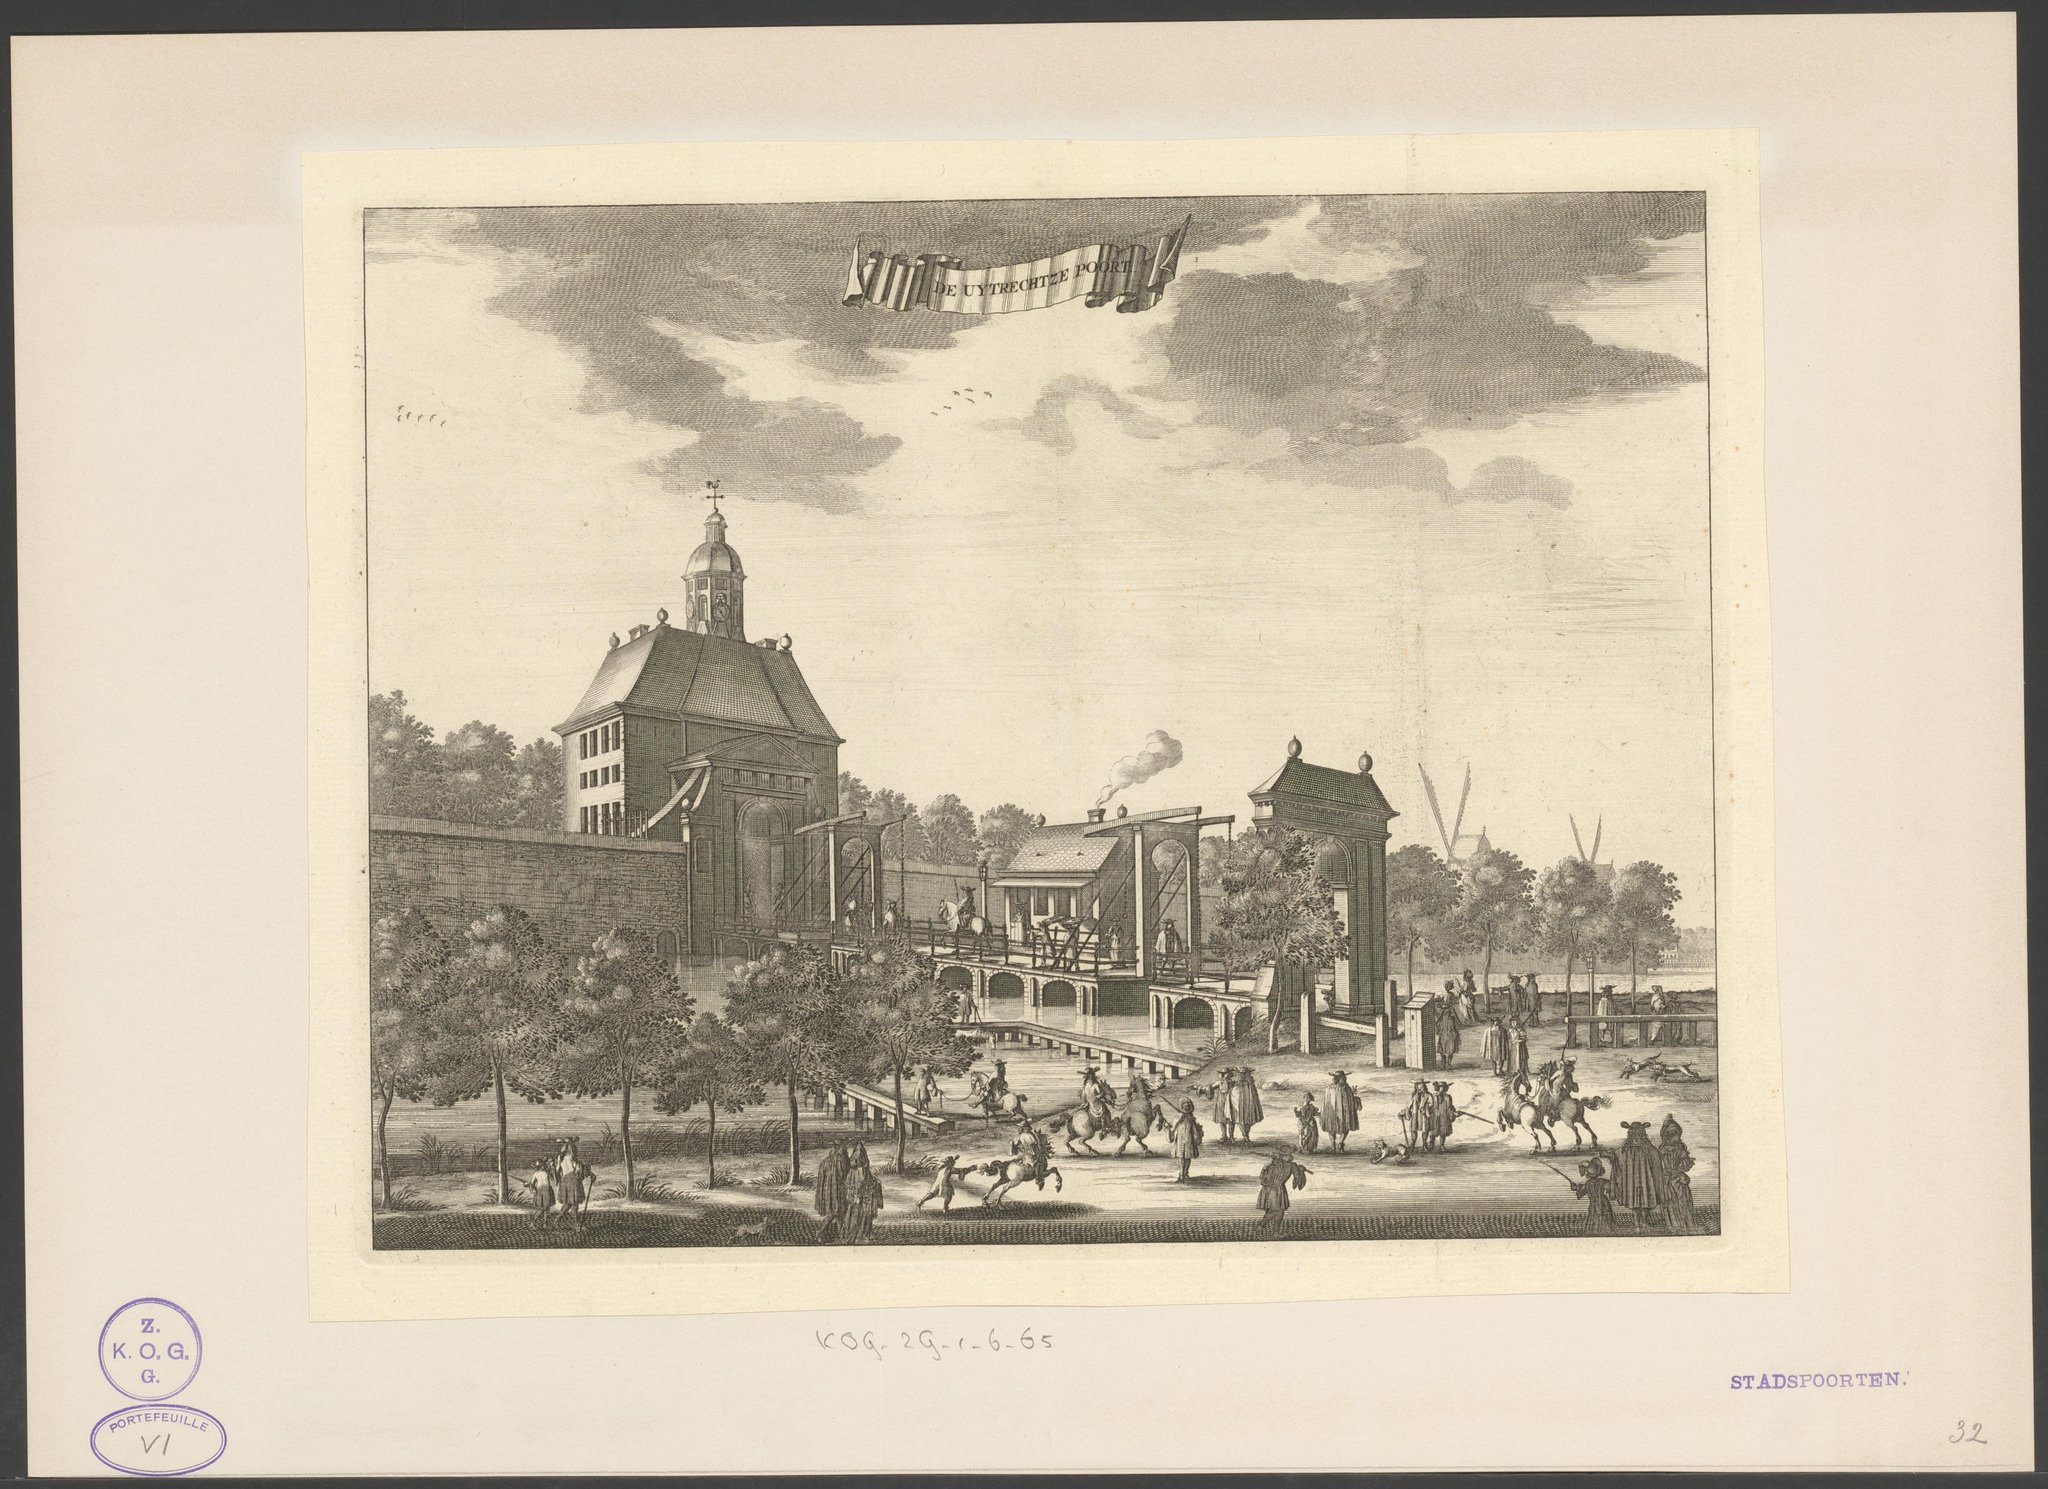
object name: print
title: Gezicht op de Utrechtsepoort in Amsterdam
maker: Anonymous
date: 1724-1726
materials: paper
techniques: engraving, etching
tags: canal, bridge, city-gate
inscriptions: collector's mark: Lugt 1641, stamp, stamp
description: Prent mogelijk uit: Commelin, Caspar. Beschryvinge van Amsterdam, zynde een naukeurige verhandelinge van desselfs eerste oorspronk uyt (…). 2 dln. 2de druk. Amsterdam: Andries van Damme et al., 1726.